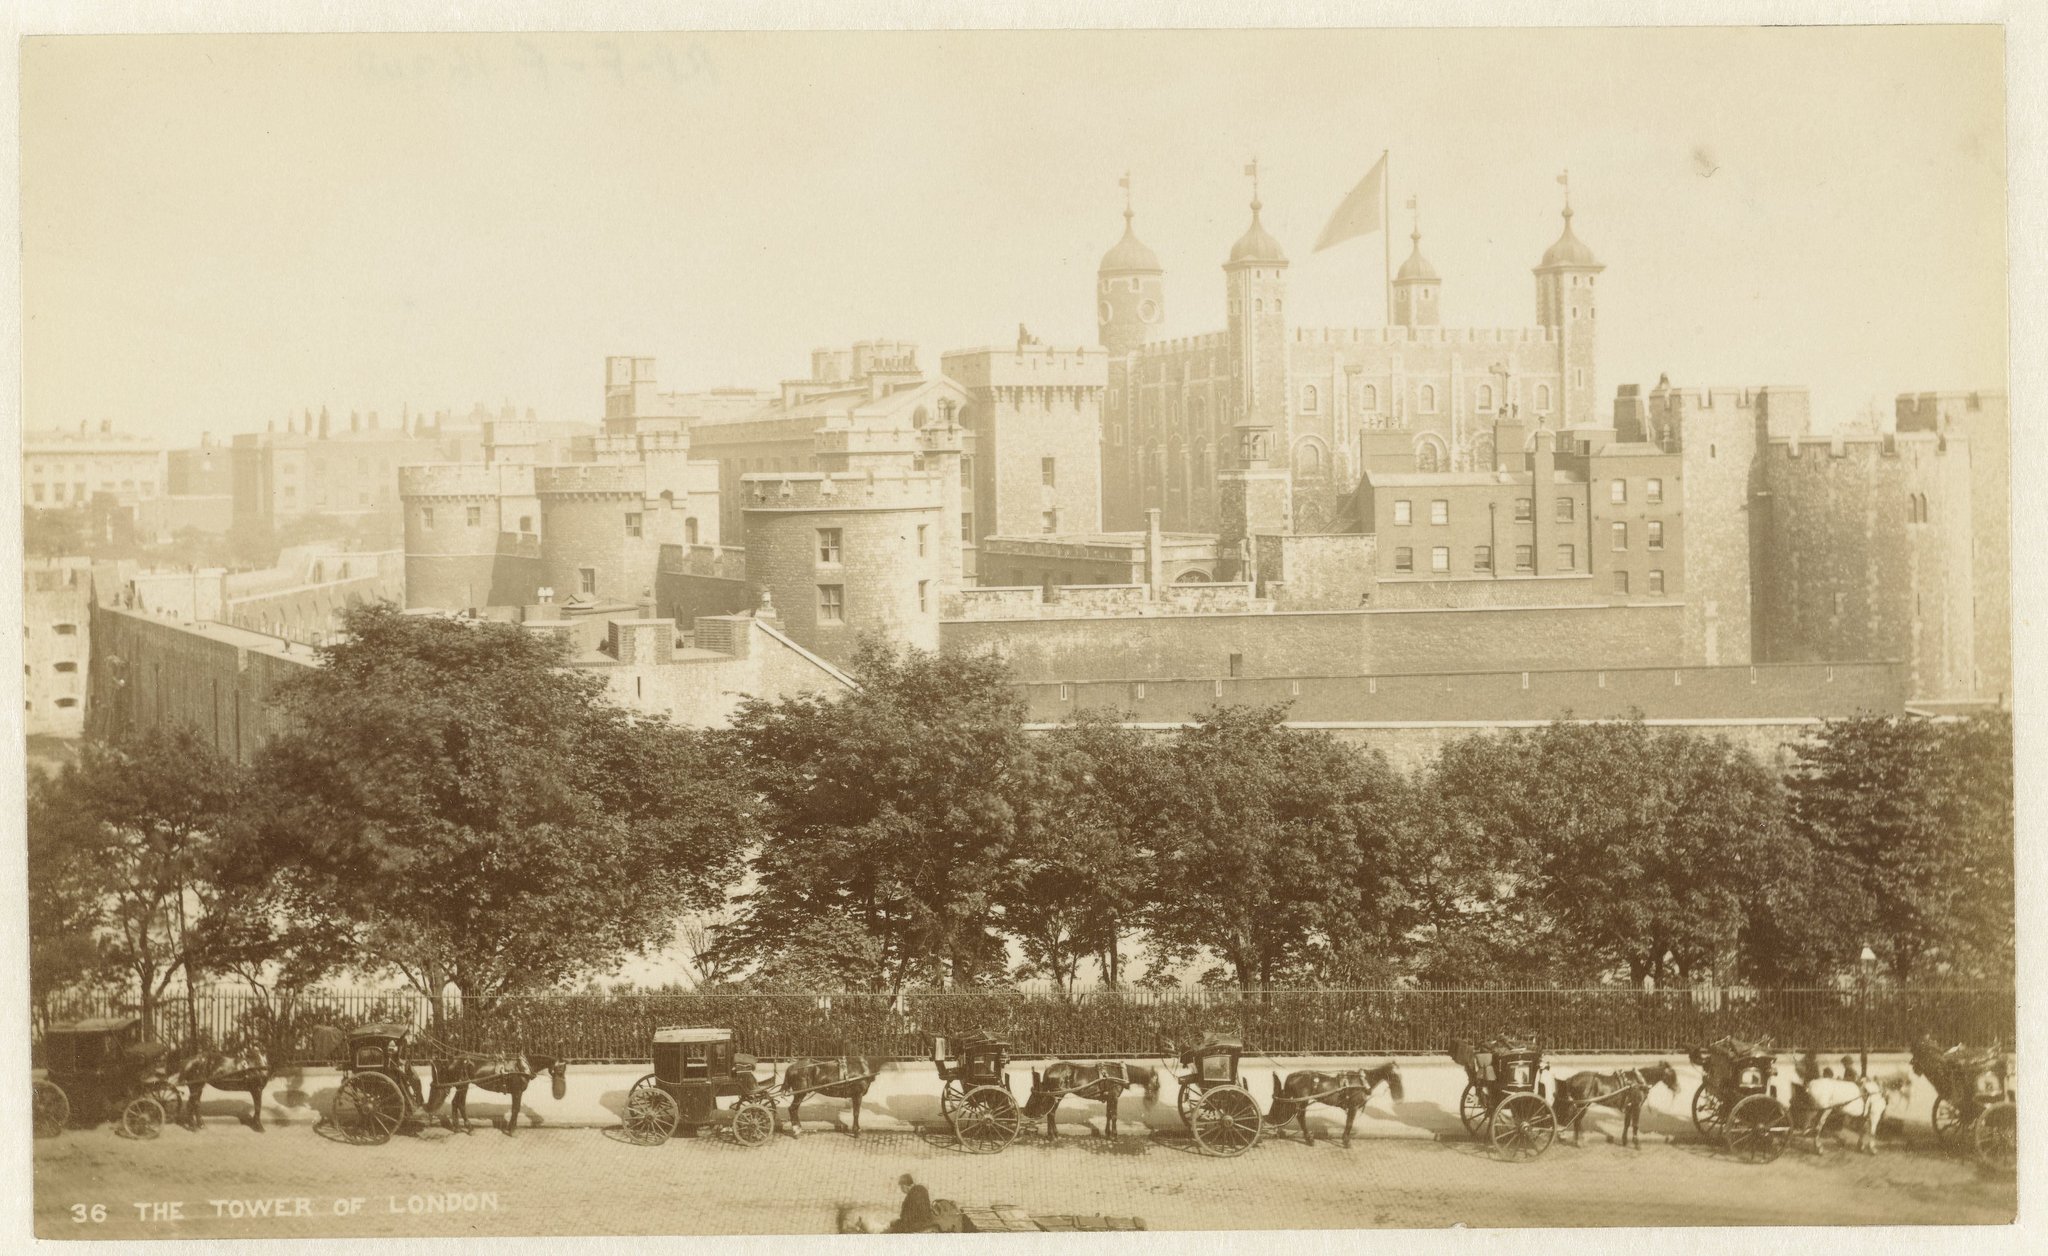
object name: photograph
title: The Tower of London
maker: james valentine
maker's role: fotograaf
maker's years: 1815-1880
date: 1851-1880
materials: paper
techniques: albumen print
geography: london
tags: fortress, passenger carriage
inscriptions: number: ‘36’